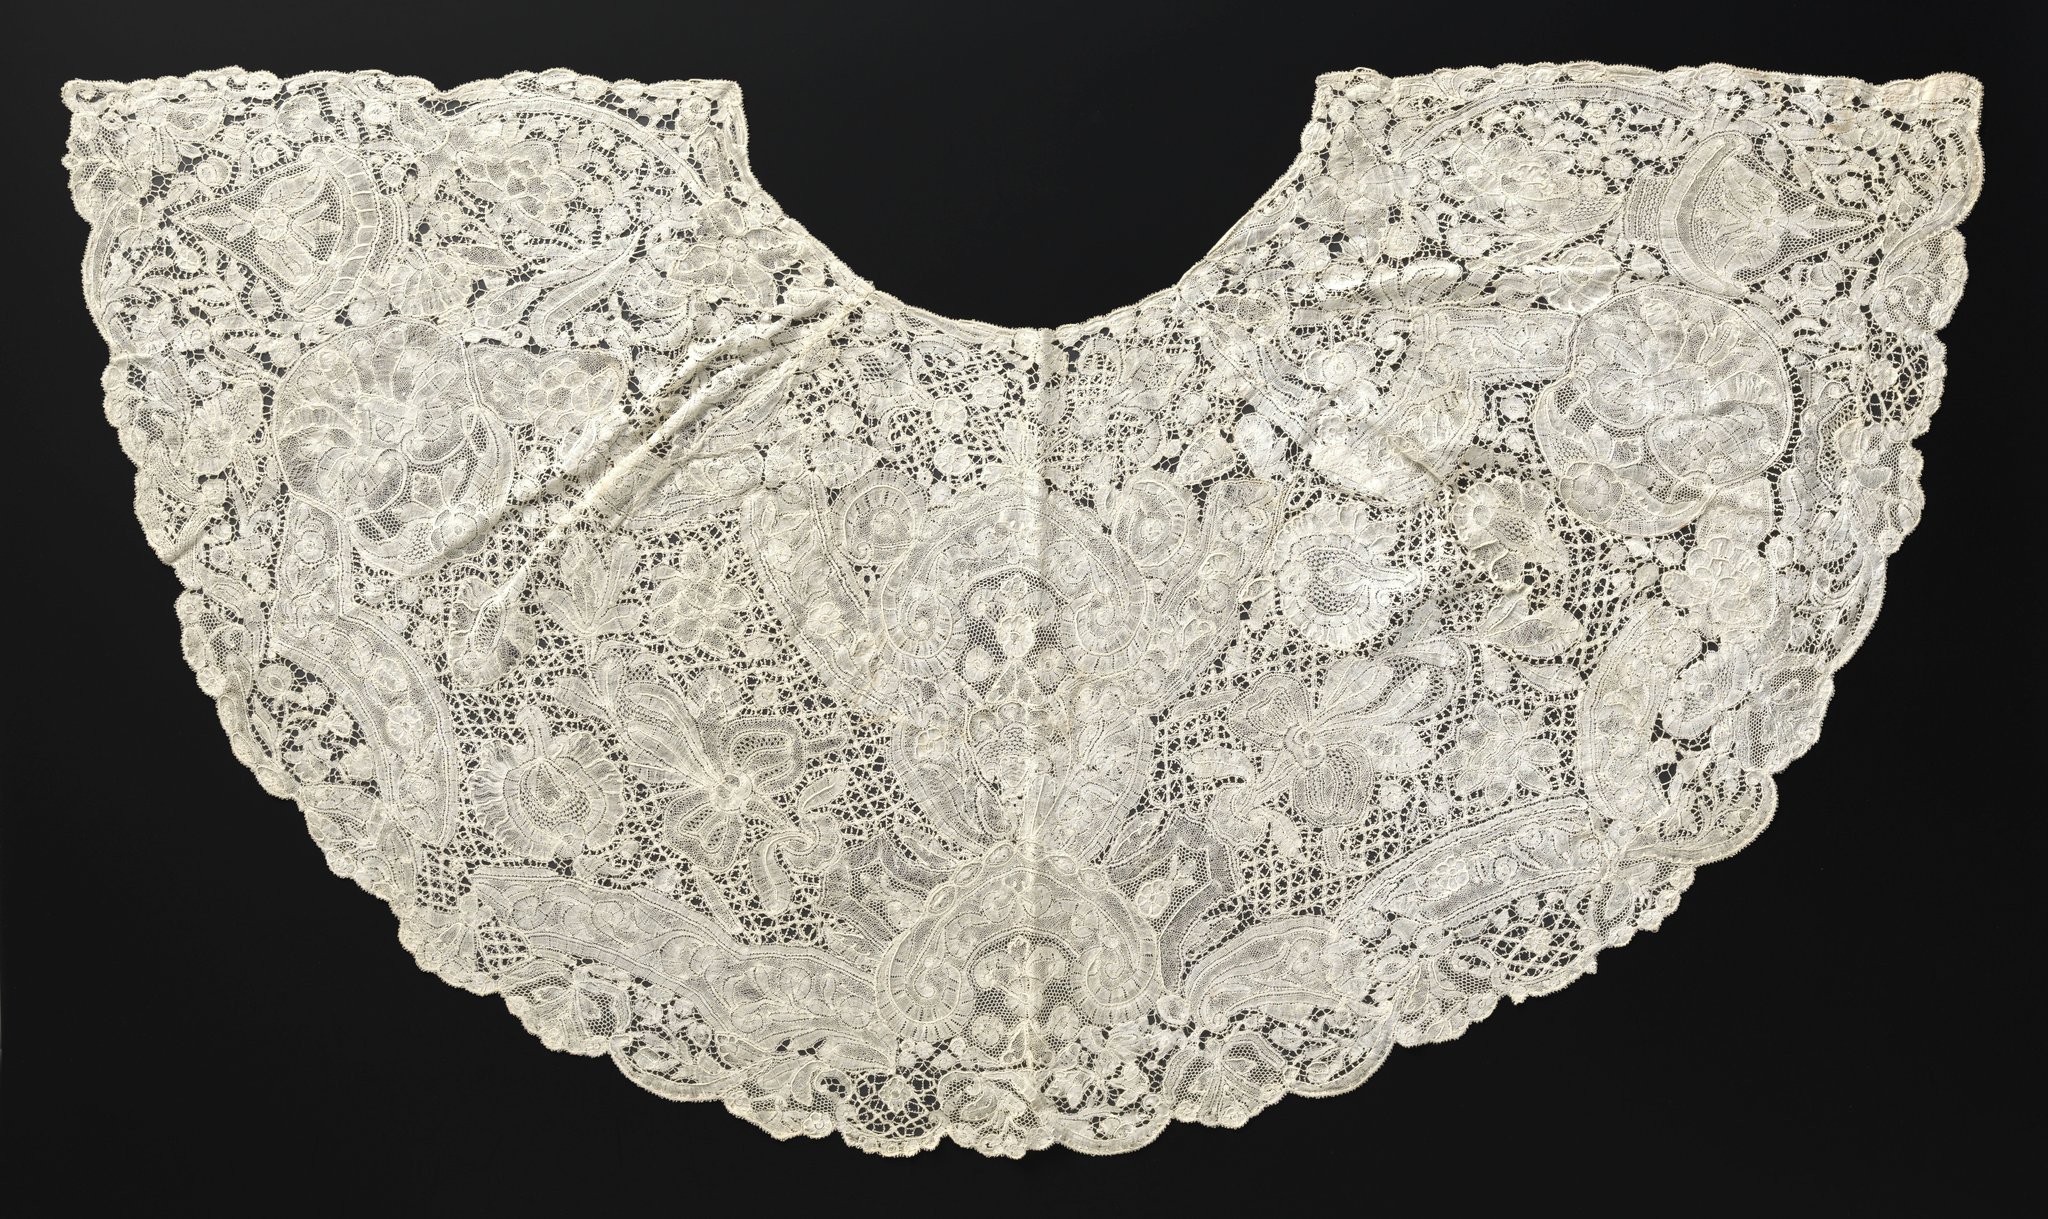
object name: collar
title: Kanunnikskraag van kloskant met symmetrisch patroon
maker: Anonymous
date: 1725-1729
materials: linen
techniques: lace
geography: europe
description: Kanunnikskraag van naturelkleurige Brabantse kloskant. Symmetrisch patroon met palmetten, voluten en bloemmotieven met verhoogde contouren. De motieven zijn gemaakt in netslag en linnenslag met reliëfcontouren. Ze zijn met elkaar verbonden door verschillende siergronden. De schulpenrand rondom de kraag komt voort uit het patroon. Niet geschulpt maar glad is de de rand die om de nek sluit. De 18e-eeuwse kraag heeft in de 19e eeuw toebehoord aan monseigneur Simon, aalmoezenier van Marie-Henriëtte, gemalin van Koning Leopold II van België.